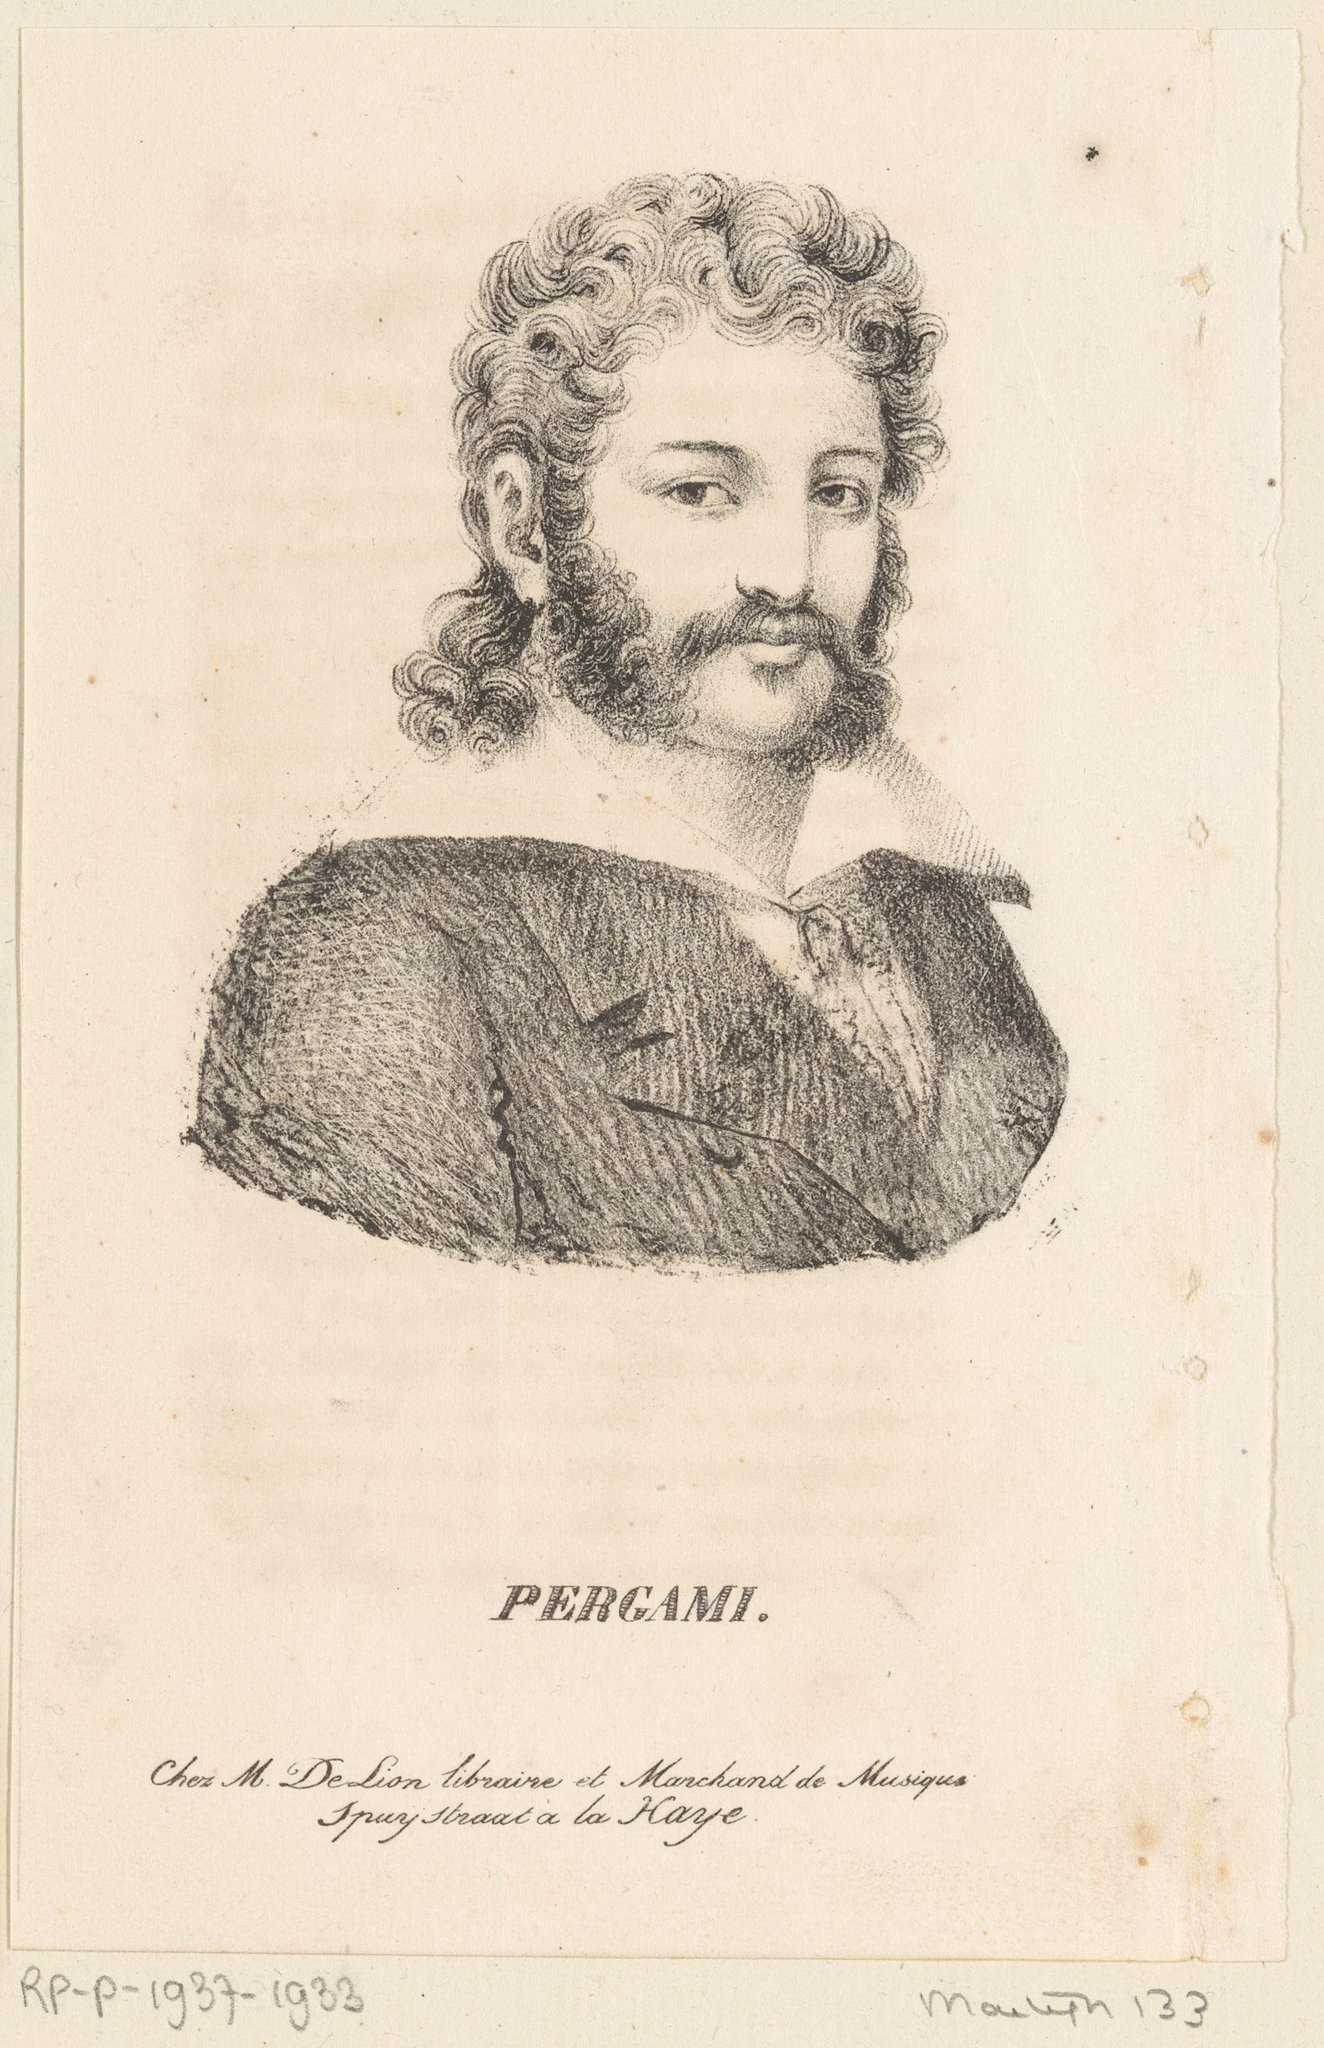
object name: print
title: Portret van Baron Pergami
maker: jean baptiste ambroise marcellin jobard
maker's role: print maker, publisher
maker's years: 1792-1861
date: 1821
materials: paper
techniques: lithograph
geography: brussels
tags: historical persons (+ (full) bust portrait)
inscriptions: collector's mark: 2760, collector's mark: Lugt 2228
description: Prent voor Reizen van Hare Majesteit, de Koningin van Engeland, en van den Baron Pergami, haren Kamerheer, door Duitschland, Italië, Griekenland, Sicilië, Tunis, Jaffa, Jeruzalem, Konstantinopel enz., gedurende de jaren 1814, 1815, 1816, 1817, 1818, 1819 en 1820, waarin zeer vele belangrijke en wetenswaardige gebeurtenissen voorkomen. Den Haag: M. de Lyon, 1821. Het portret is opgezet samen met het portret van de Koningin en de eerste pagina's van het boek.